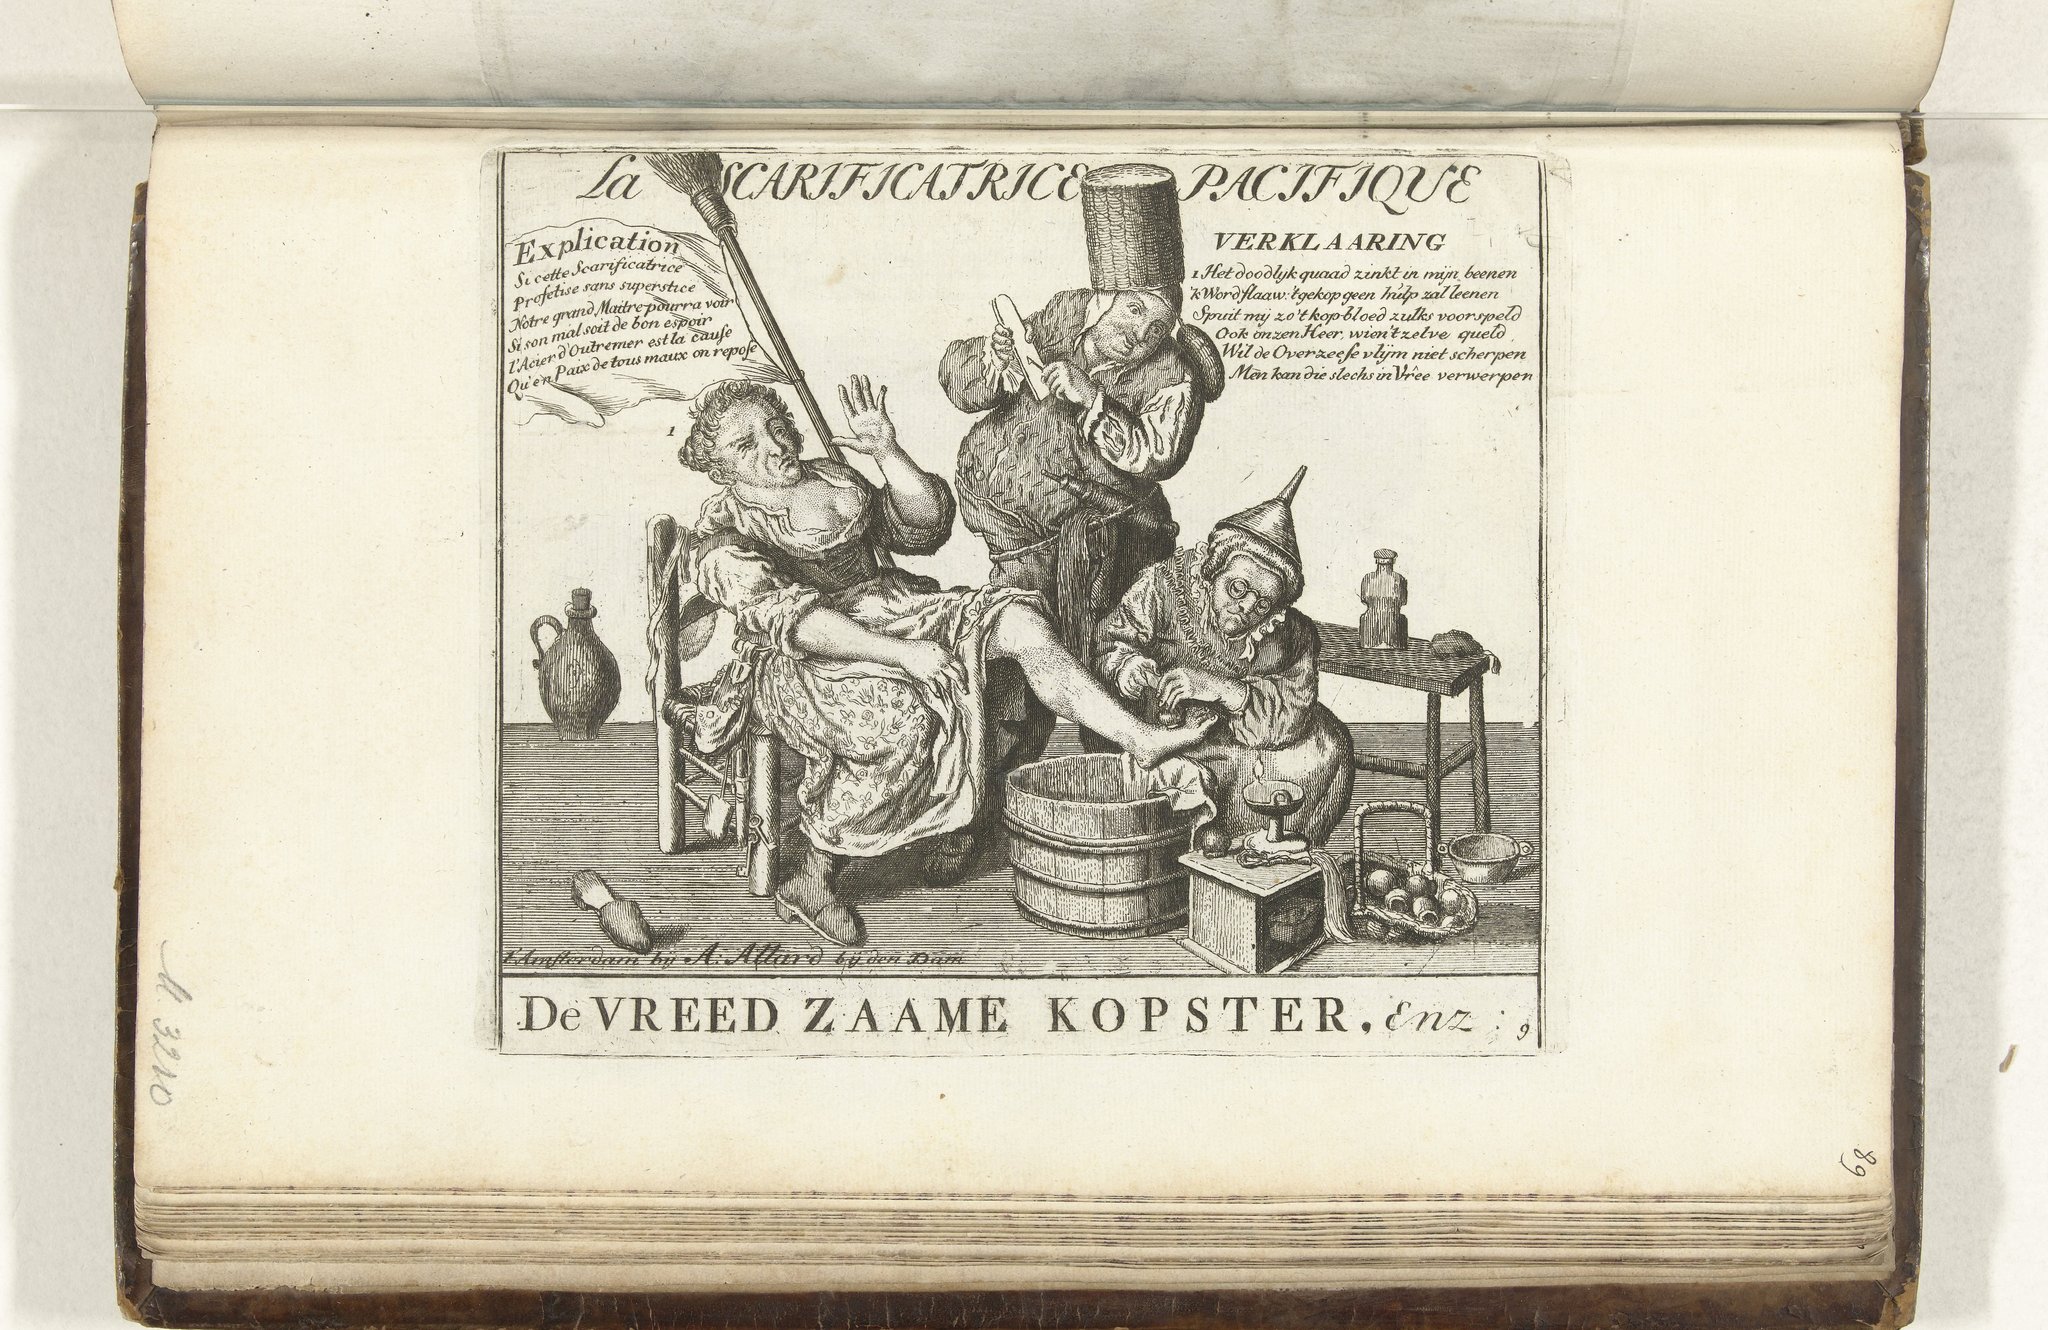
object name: cartoon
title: De vreedzame kopster, 1713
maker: abraham allard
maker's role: print maker, publisher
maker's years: 1676-1725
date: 1713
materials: paper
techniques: etching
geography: amsterdam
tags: london, anna stuart (koningin van engeland en schotland), bleeding, blood-letting, e.g.: with the aid of cupping-glasses, unprofessional or illegal practice, popular medicine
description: Spotprent waarin een vrouw door een kopster aan haar been wordt behandeld, een chirurgijn kijkt toe. Toespeling op de rol van koningin Anna in de vredesonderhandelingen voor de Vrede van Utrecht, 1713. Genummerd rechtsonder: 9. In de plaat verzen in het Nederlands en Frans. Onderdeel van een groep van 28 nieuwe en oude platen aangepast ter illustratie van de Vrede van Utrecht in 1713. Onderdeel van het prentwerk uitgegeven onder de verzameltitel 't Lust-Hof van Momus met de gebundelde series van spotprenten tijdens de jaren 1701-1713 van de Spaanse Successieoorlog.